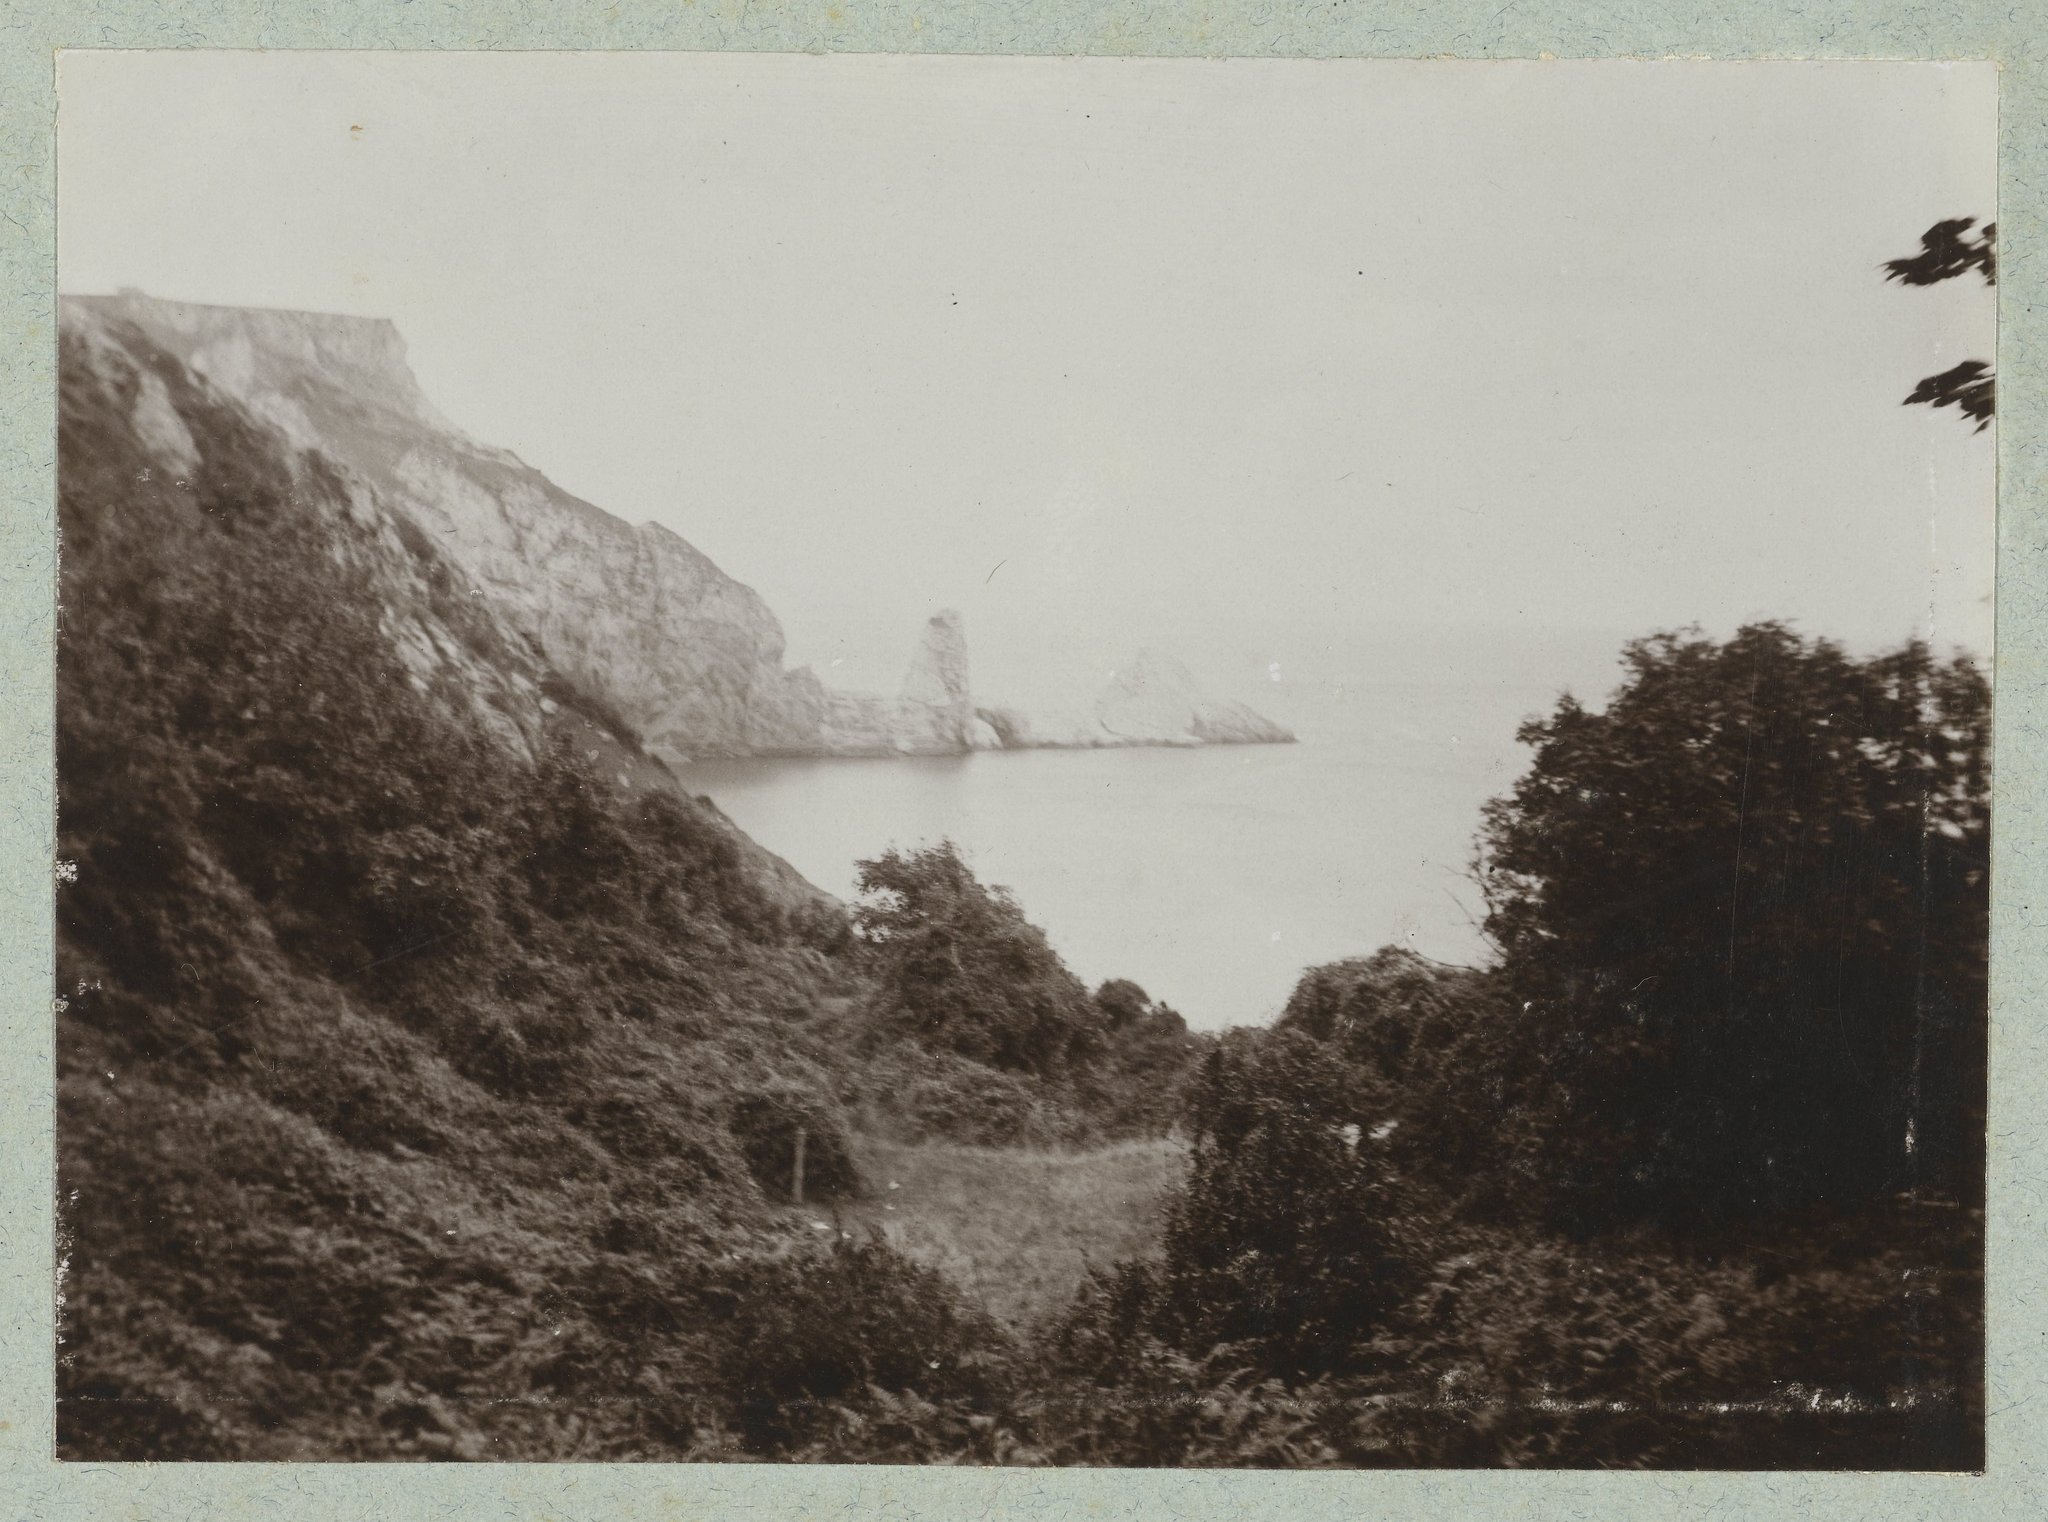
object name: photograph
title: Photographieën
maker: frits freerks fontein fz.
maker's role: fotograaf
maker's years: 1882-1928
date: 1901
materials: cardboard, paper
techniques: gelatin silver print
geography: england